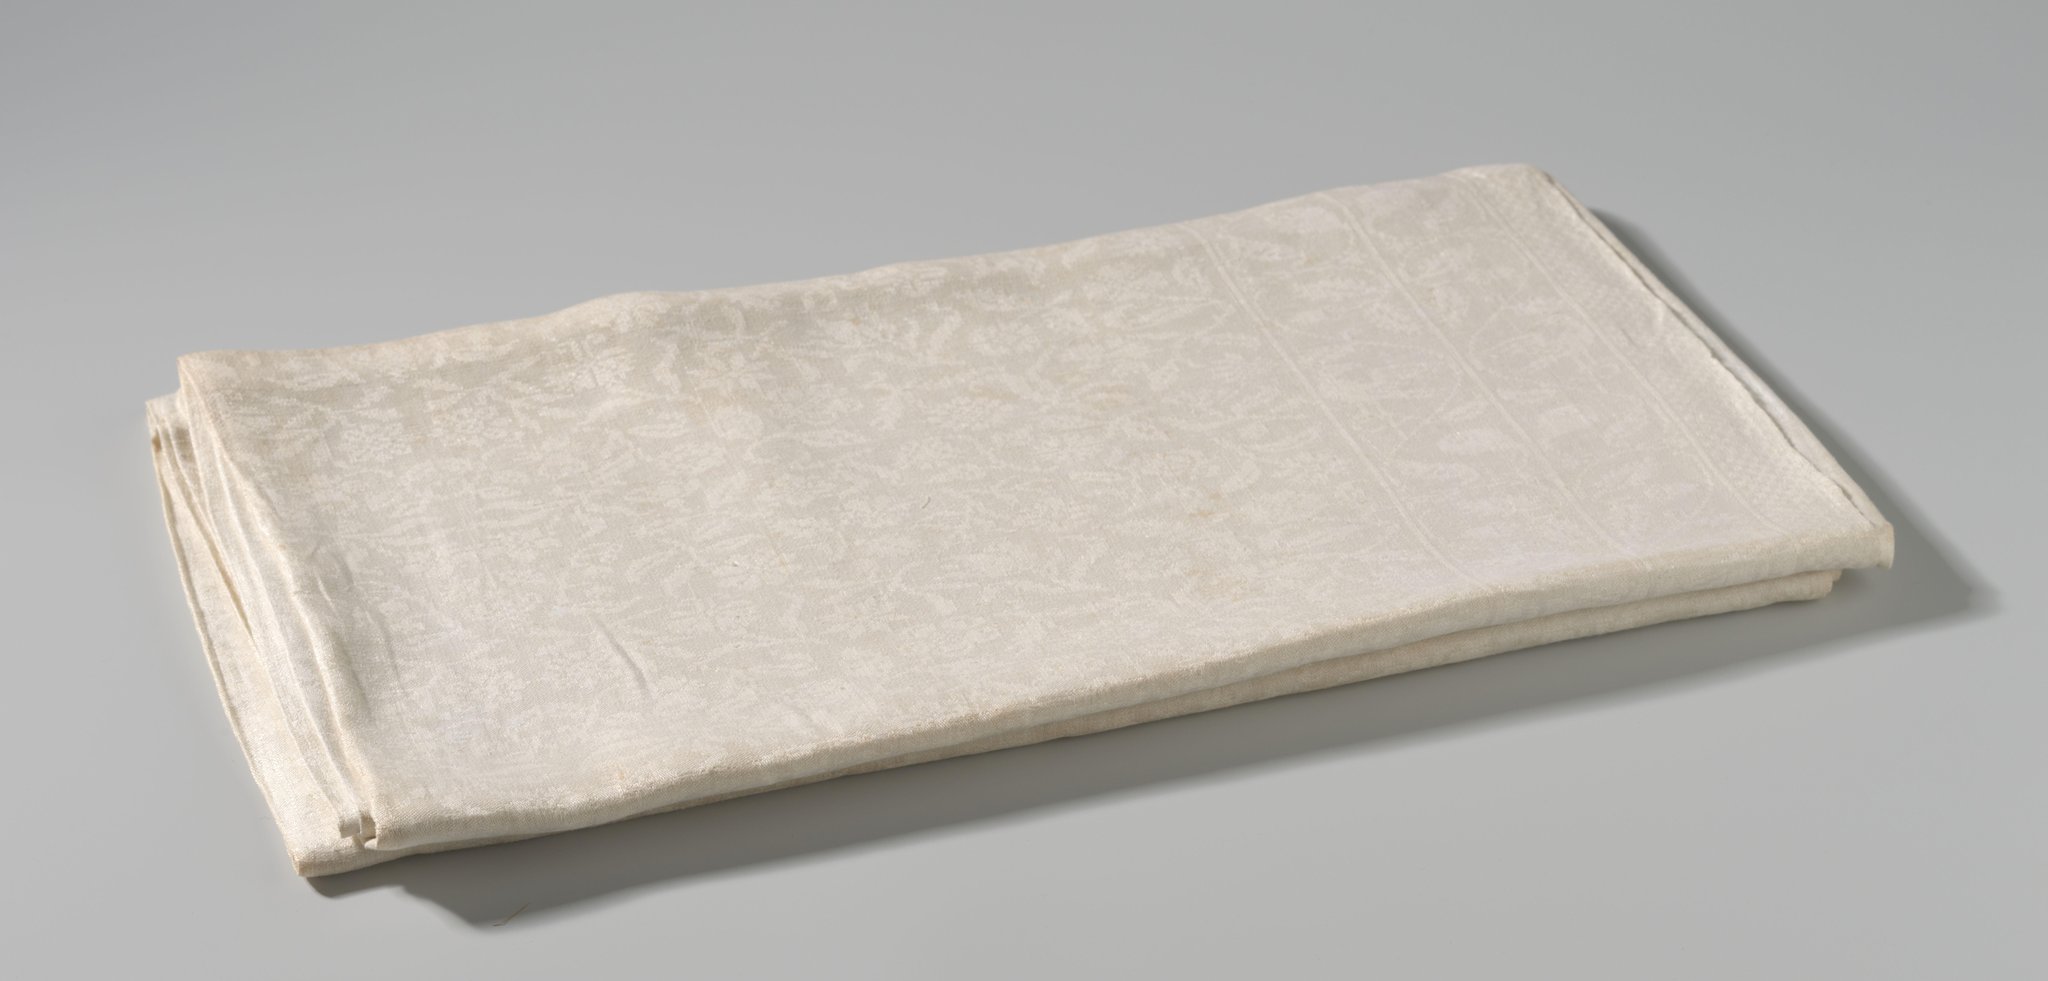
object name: tablecloth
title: Tafellaken met een bloempatroon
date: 1650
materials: linen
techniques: damask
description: Tafellaken van linnendamast met een bloempatroon. Middenveld: Het symmetrisch patroon vertoont losse takken met rozen of tulpen, en kievits- of rozetvormige bloemen. Staande randen: symmetrische tekening van slingerende ranken en vogels; daarbuiten: blokkenrand.